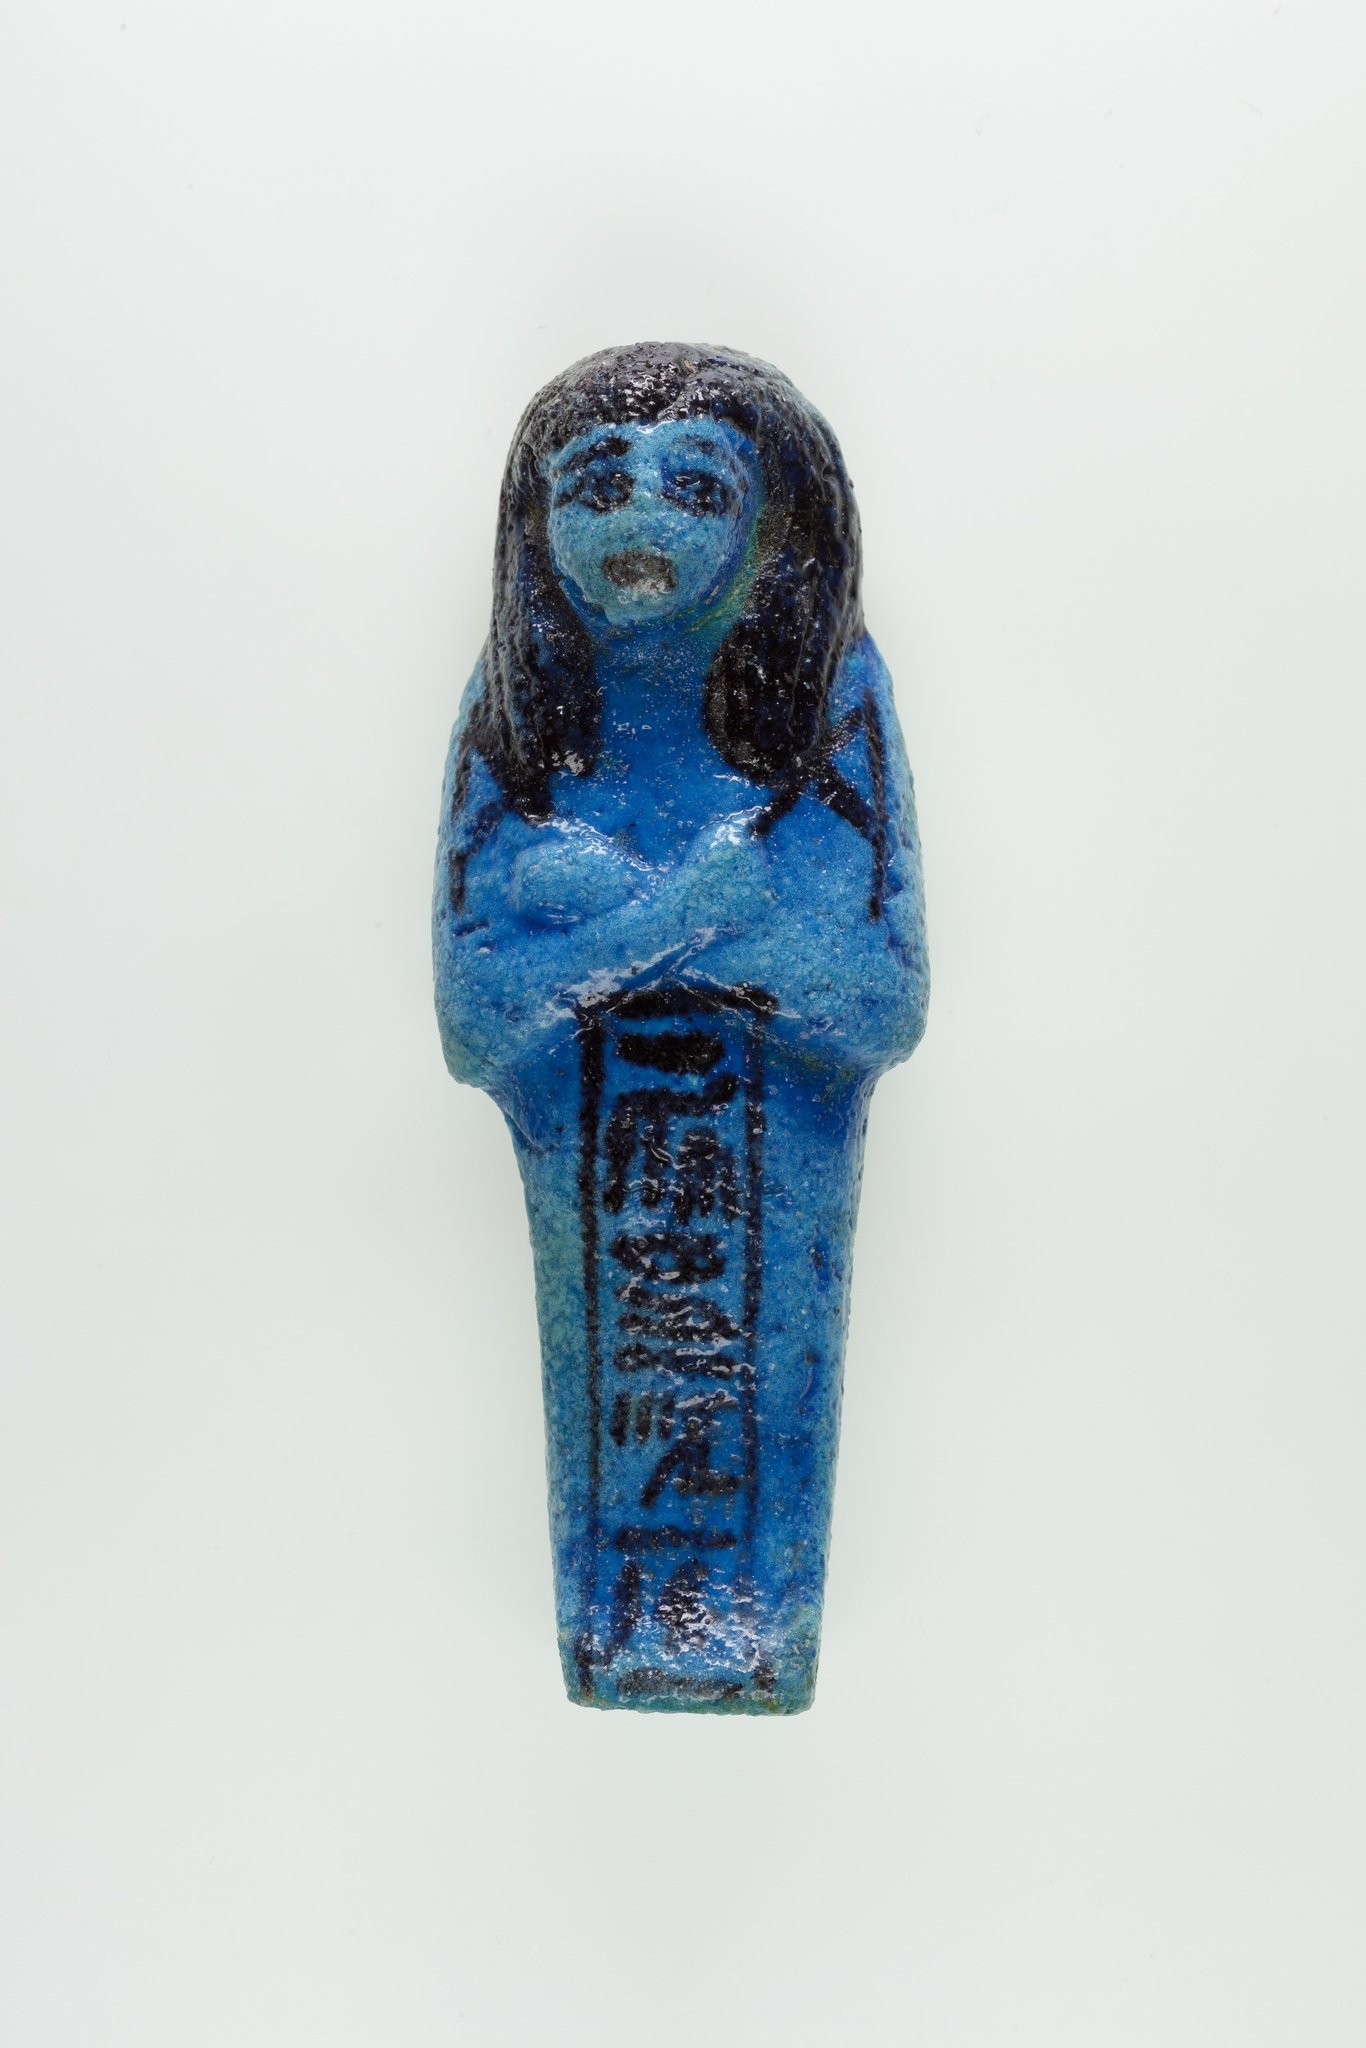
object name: shabti, worker, nauny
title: Worker Shabti of Nauny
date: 1050 BCE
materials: faience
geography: egypt